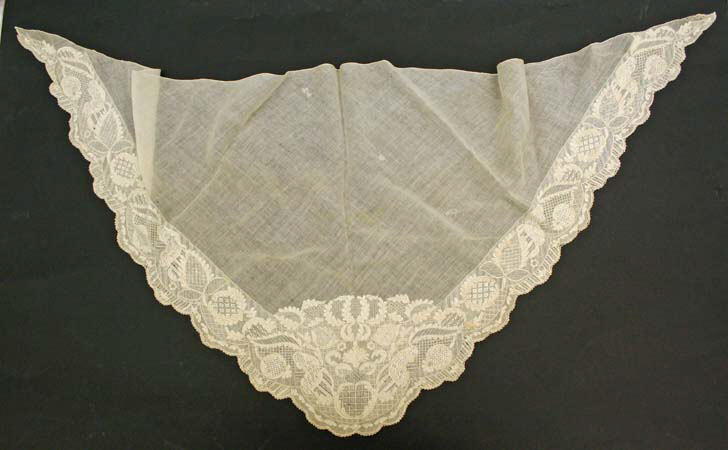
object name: fichu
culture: french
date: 1789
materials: cotton